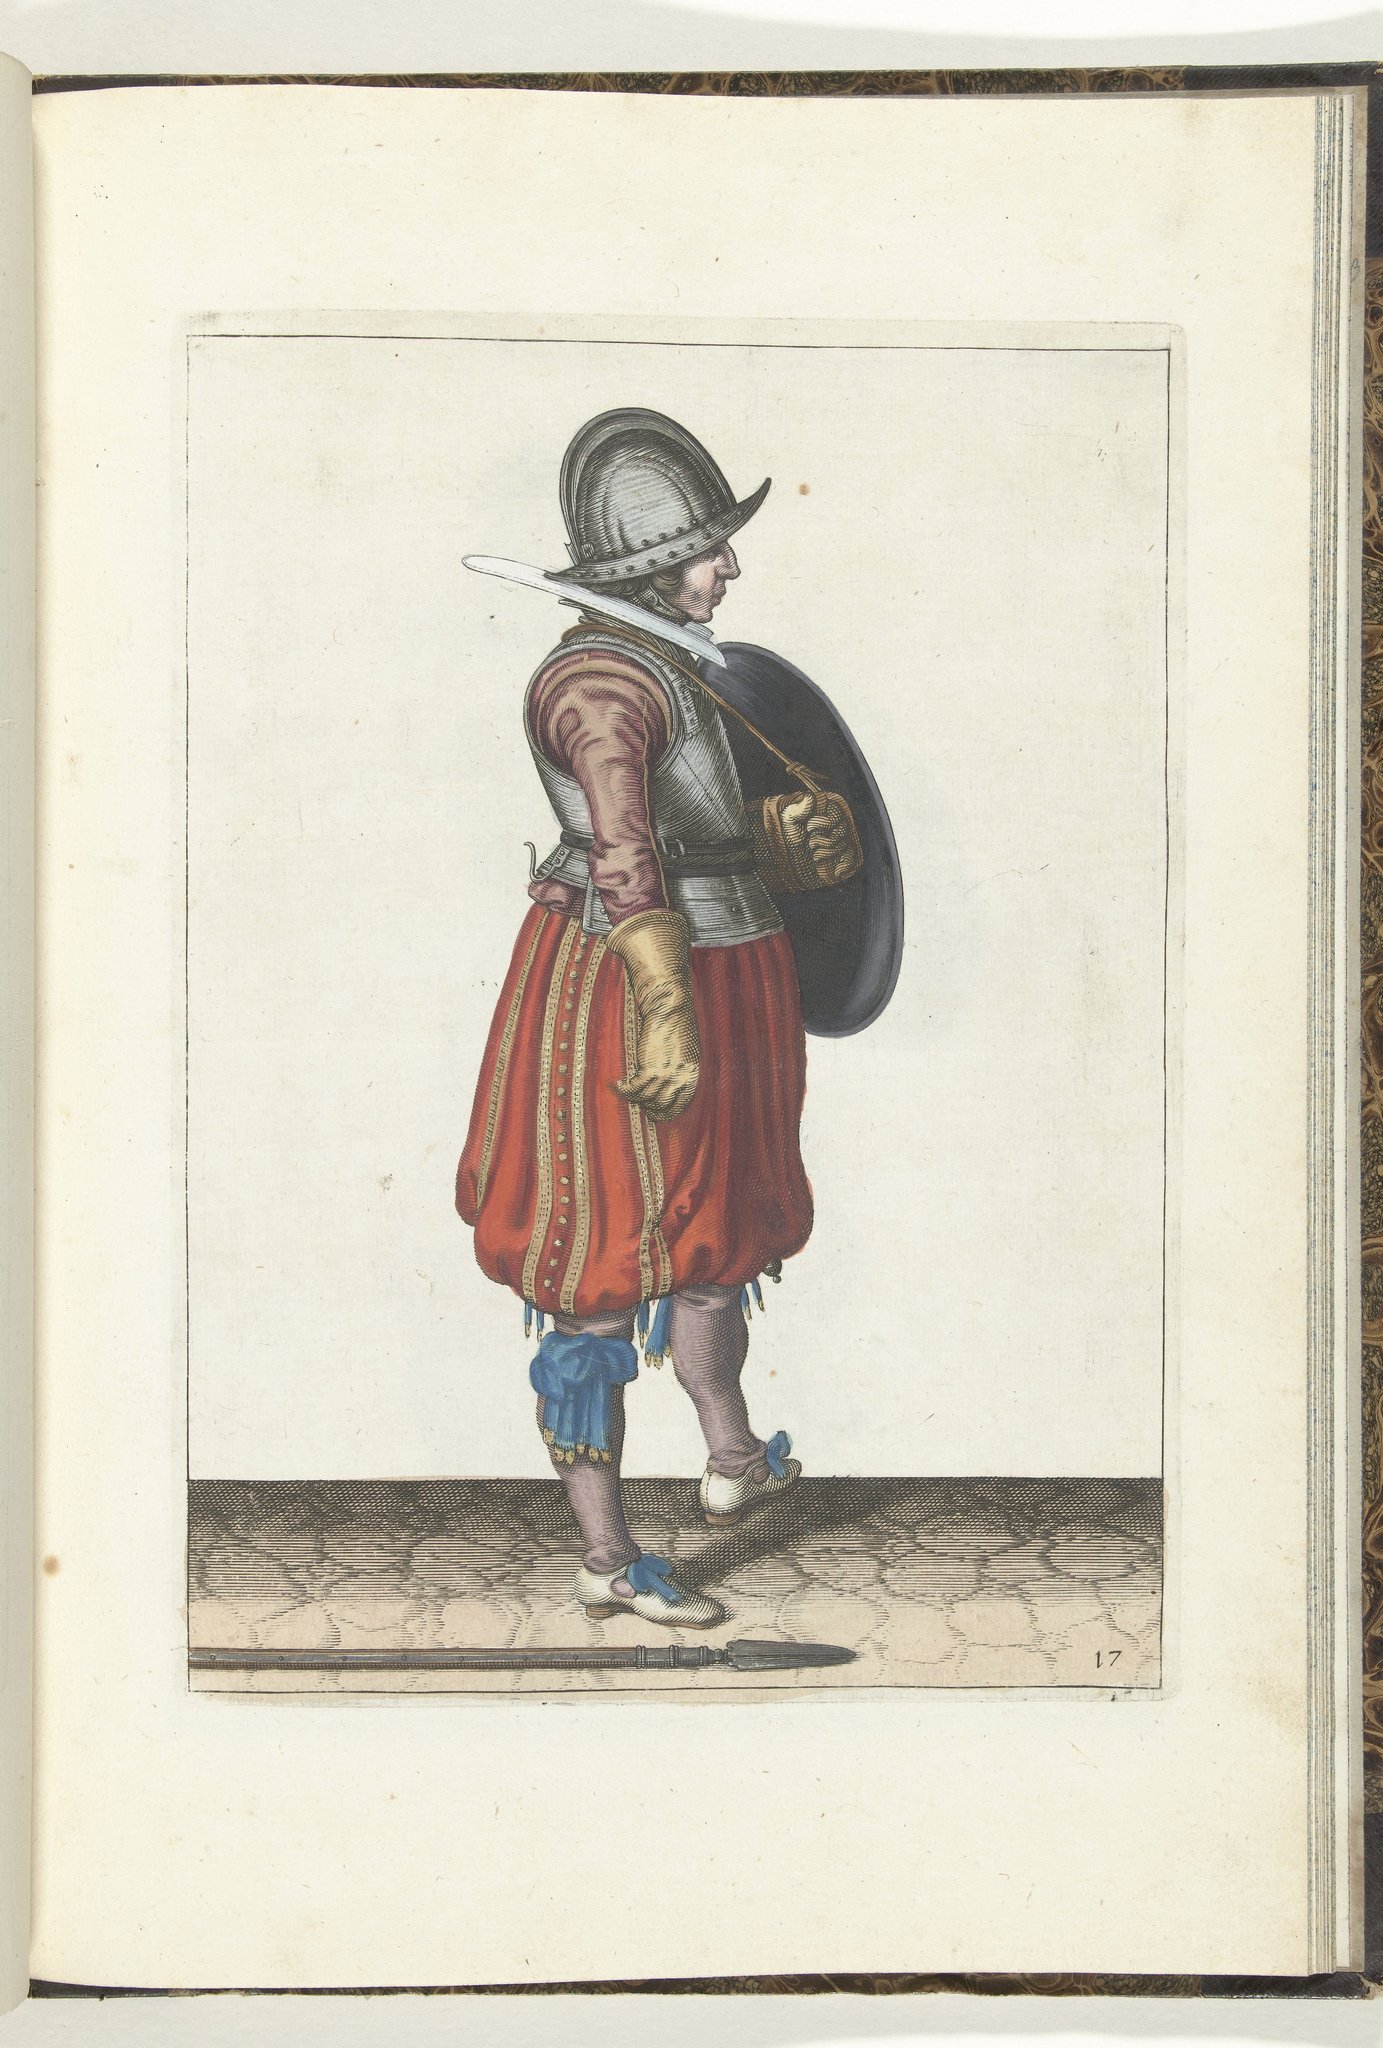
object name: print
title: De exercitie met schild en spies: de soldaat met het schild gereed en de spies naast zijn rechtervoet op de grond (nr. 17), 1618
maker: Anonymous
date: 1616-1618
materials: paper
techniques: engraving, hand coloring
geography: northern netherlands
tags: the hague, maurice (prince of orange), handling of weapons ~ military training, weapons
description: Illustratie in: Adam van Breen, Nassauische Waffenhandelung [incompleet exemplaar], 1618?, plaat 17. Dit is een Duitse editie van Adam van Breens De Nassausche Wapen-Handelinge, van Schilt, Spies, Rappier ende Targe : beyde figuerlick afgebeelt, ende gestelt na de nieu ordening [van] ... Maurits van Nassau, 's-Gravenhage, [Aert Meuris] 1618. In het exemplaar in de collectie van de Rijksmuseum Research Library (326 F 23).